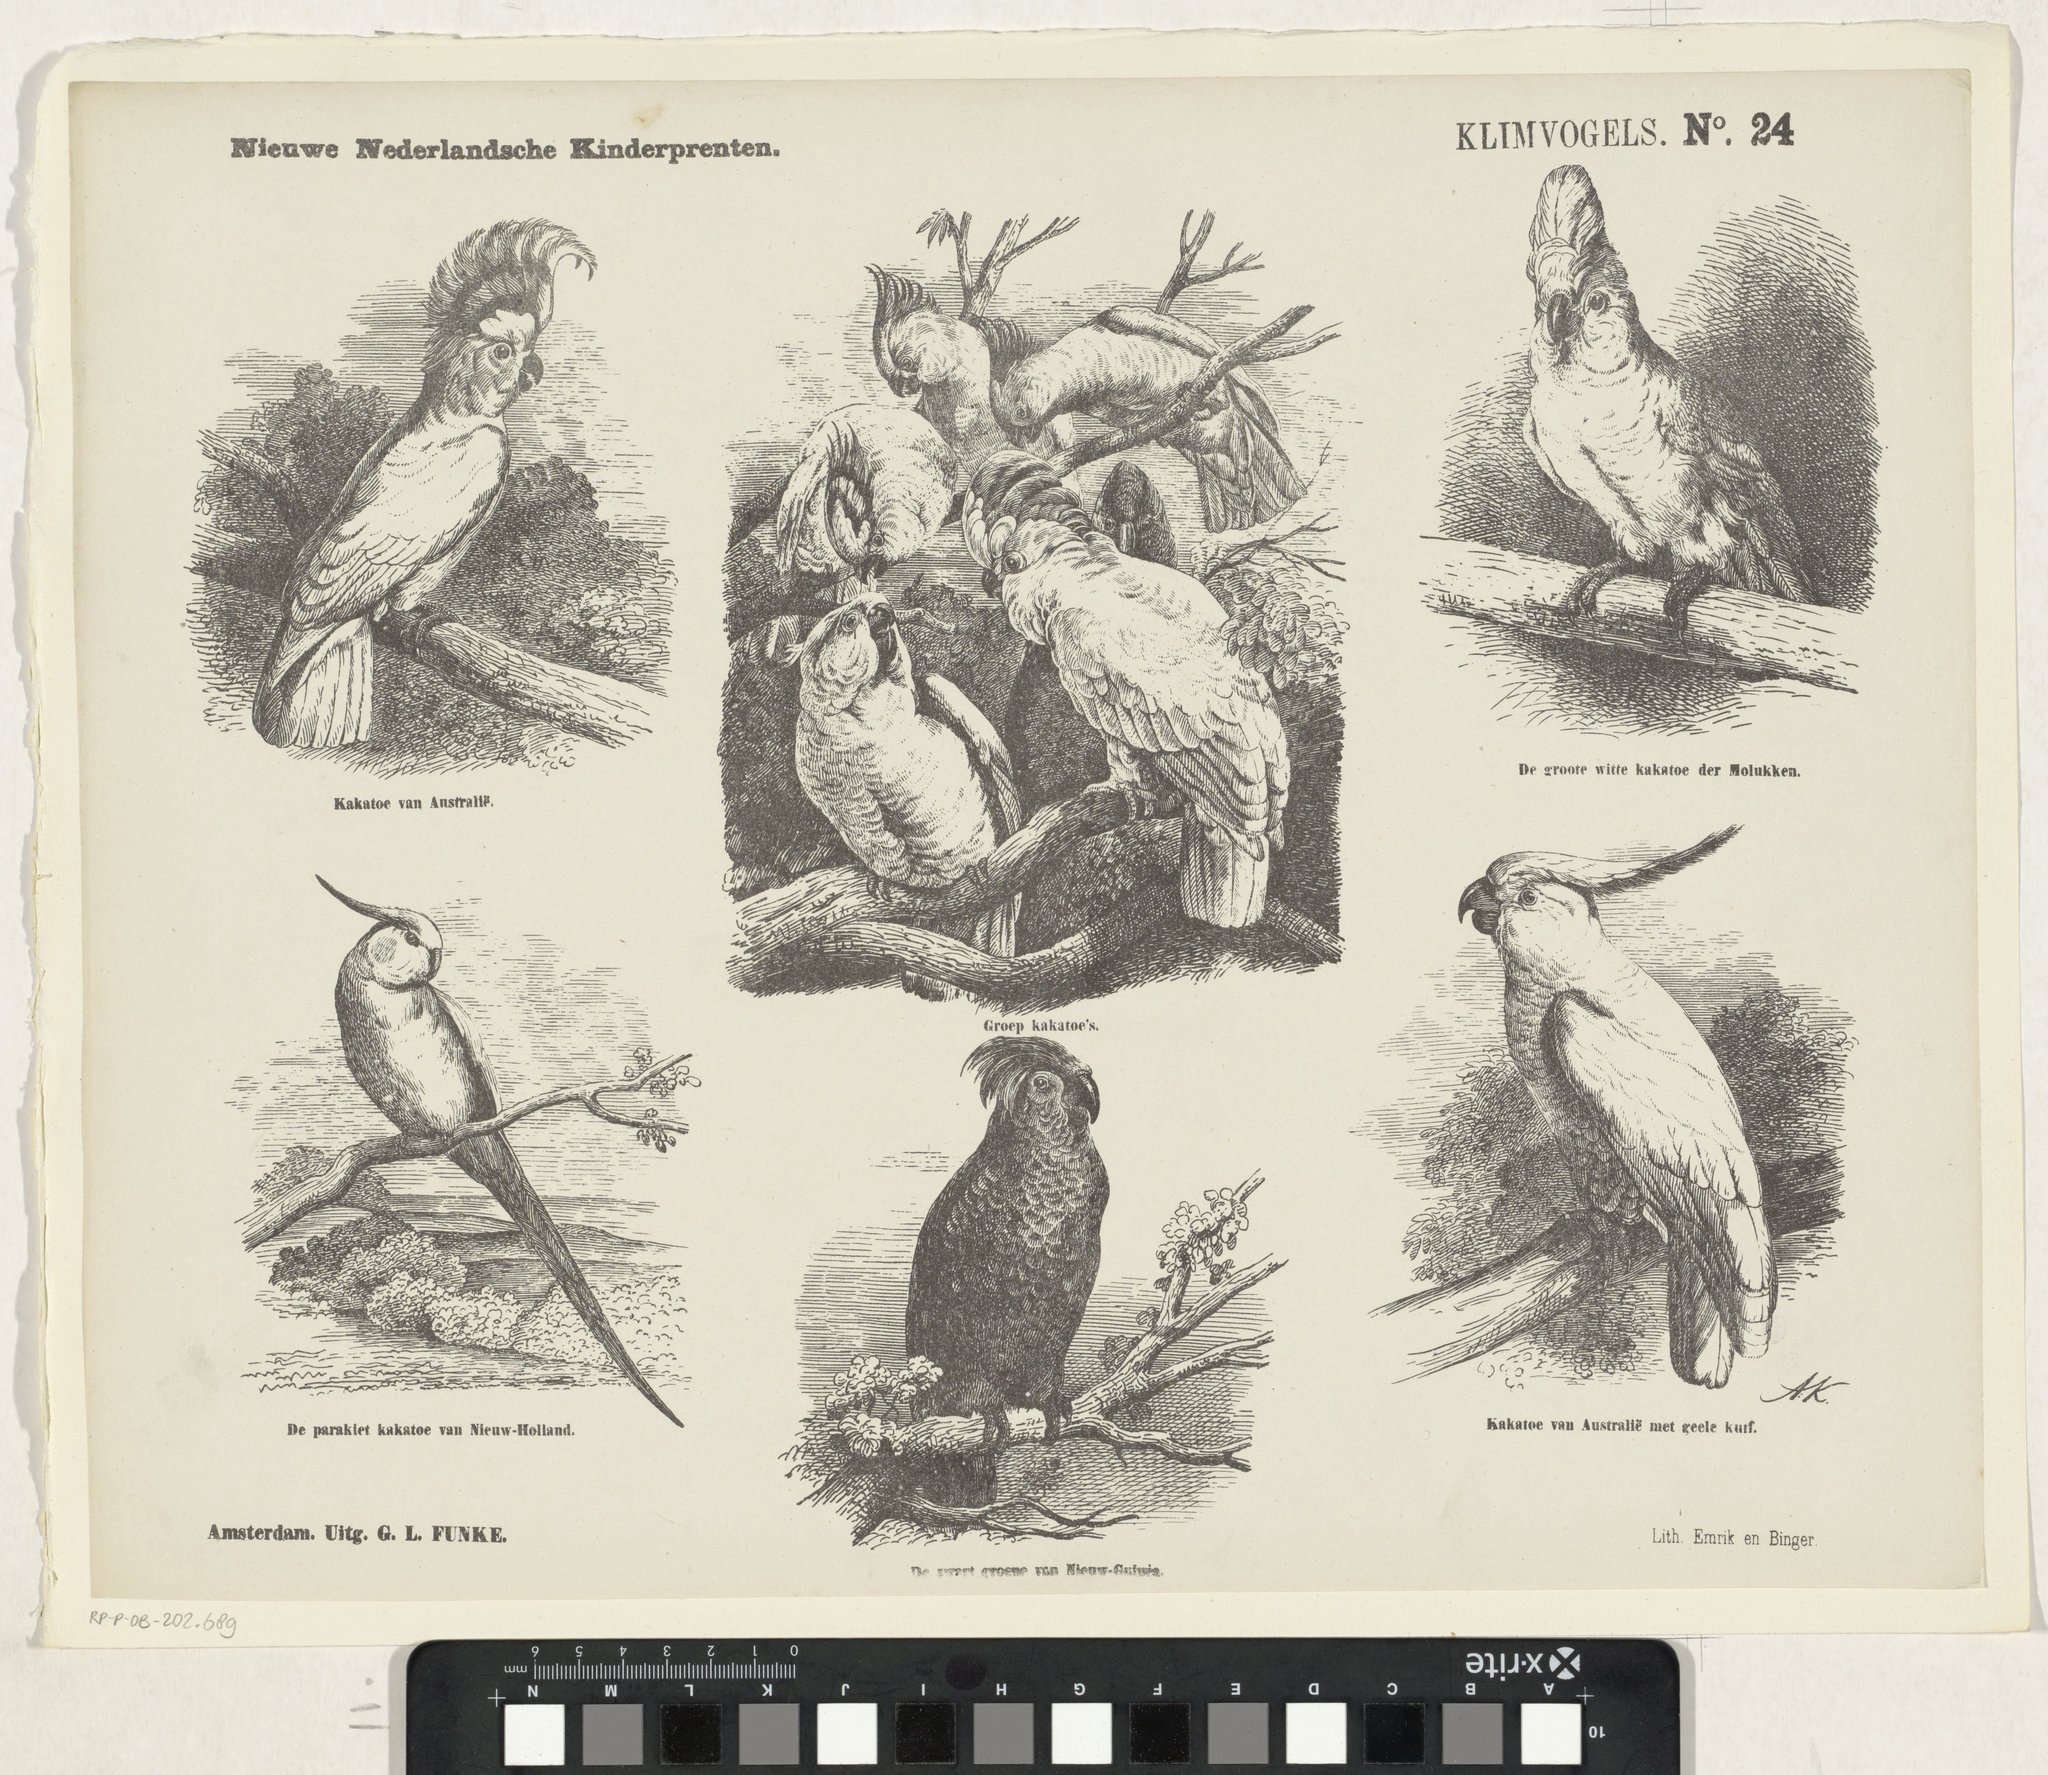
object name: print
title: Klimvogels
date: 1865-1875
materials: paper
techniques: letterpress printing, lithograph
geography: amsterdam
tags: ornamental birds: cockatoo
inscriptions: collector's mark: Lugt 2760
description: Blad met 6 voorstellingen van kaketoes. Onder elke afbeelding een onderschrift. Genummerd rechtsboven: No. 24.